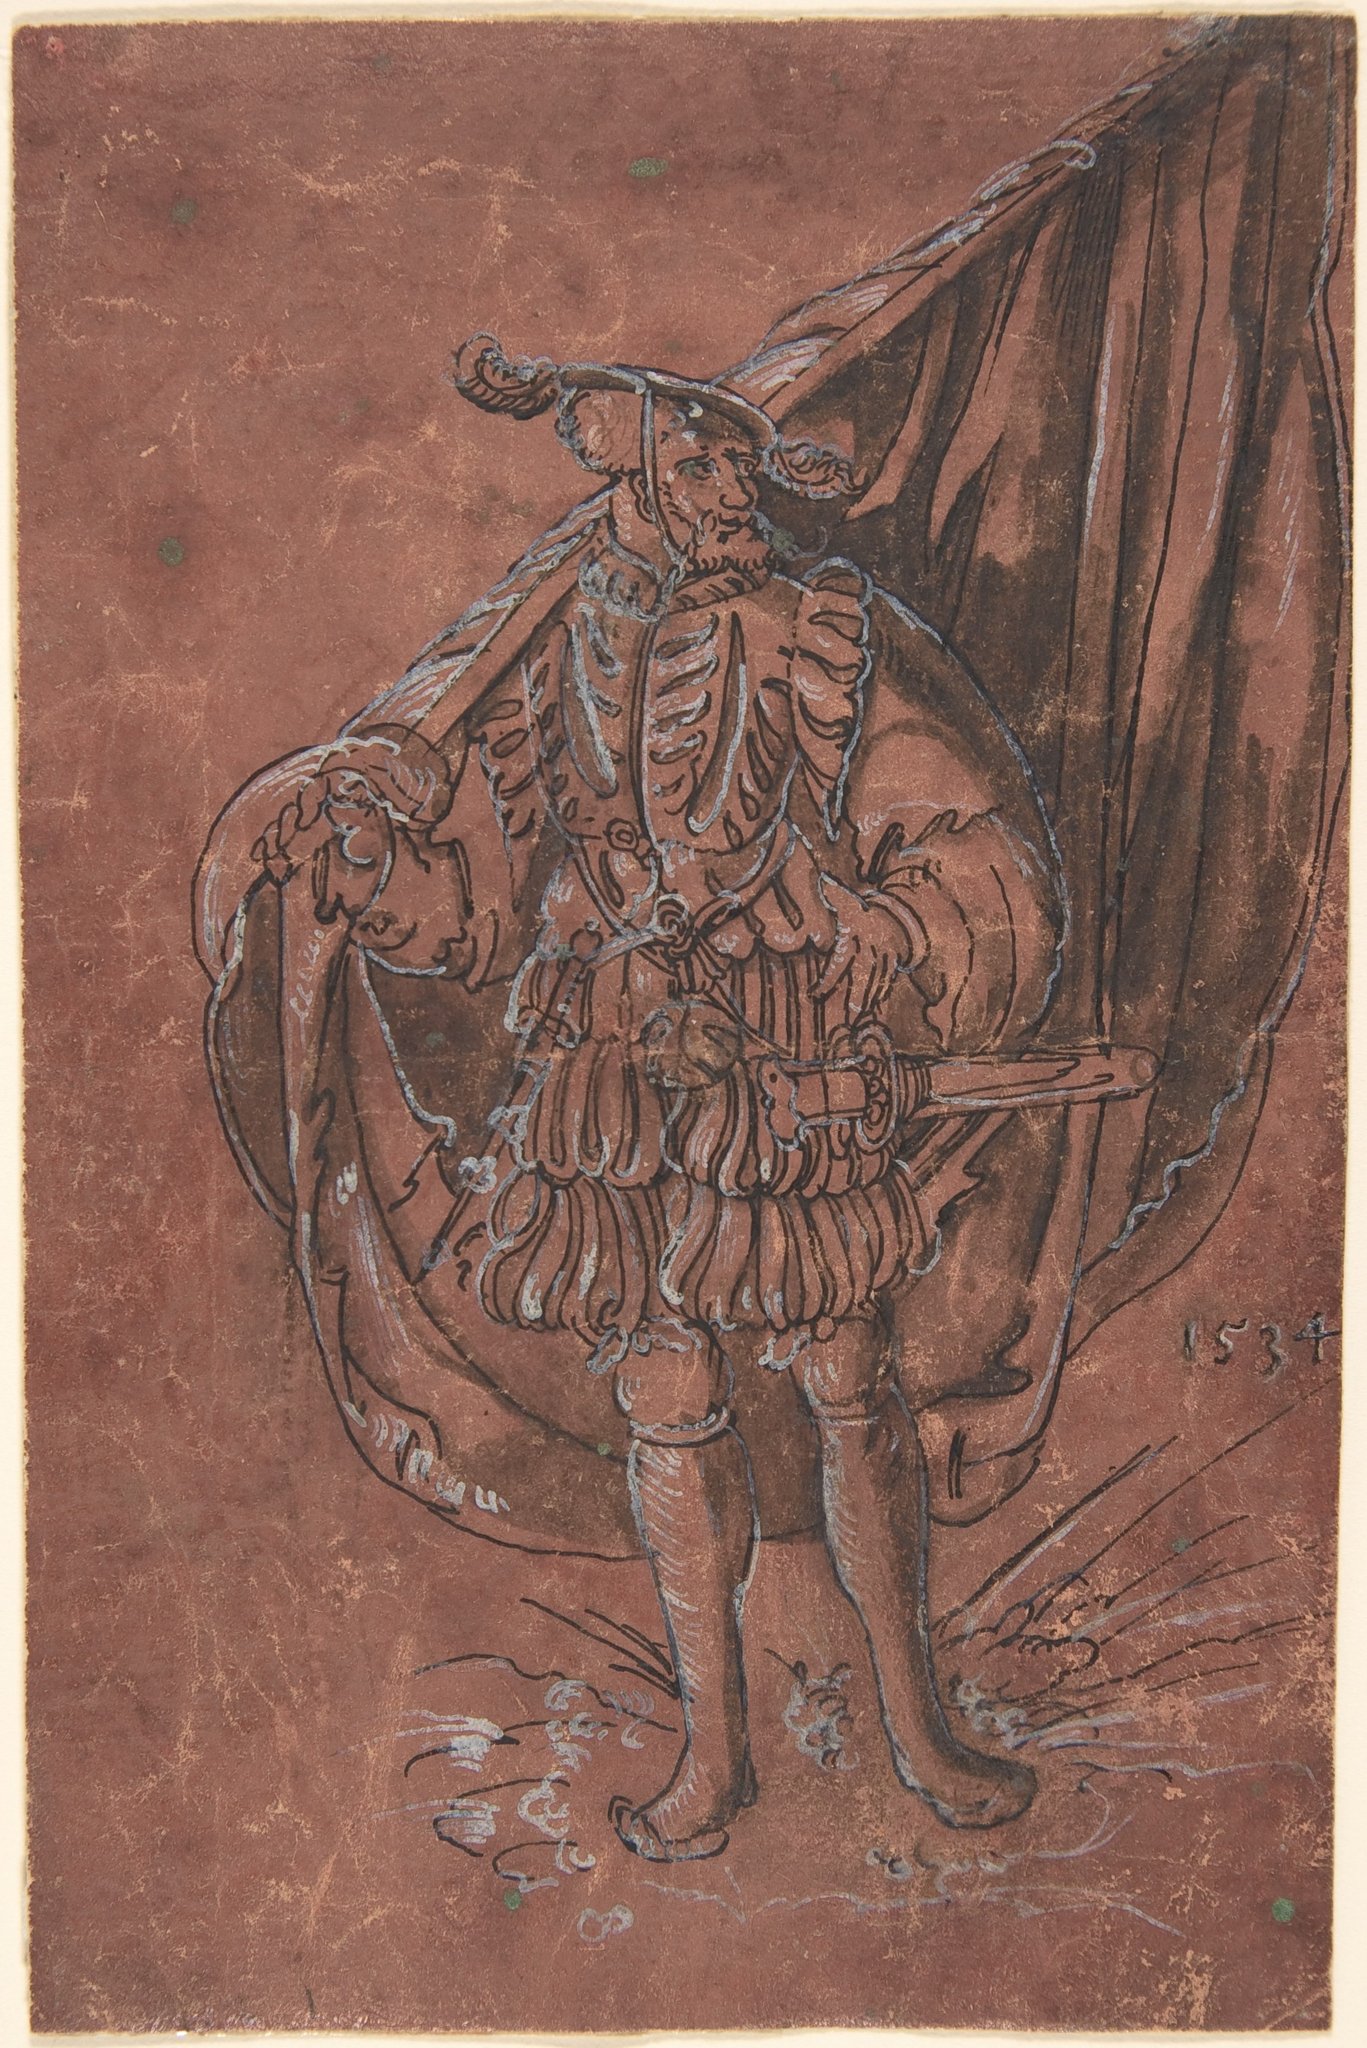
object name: drawing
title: A Standard Bearer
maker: anonymous, german, 16th century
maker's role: artist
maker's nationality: german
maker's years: 1500-1600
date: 1534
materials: ink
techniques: brush, heightening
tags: swords,men,flags